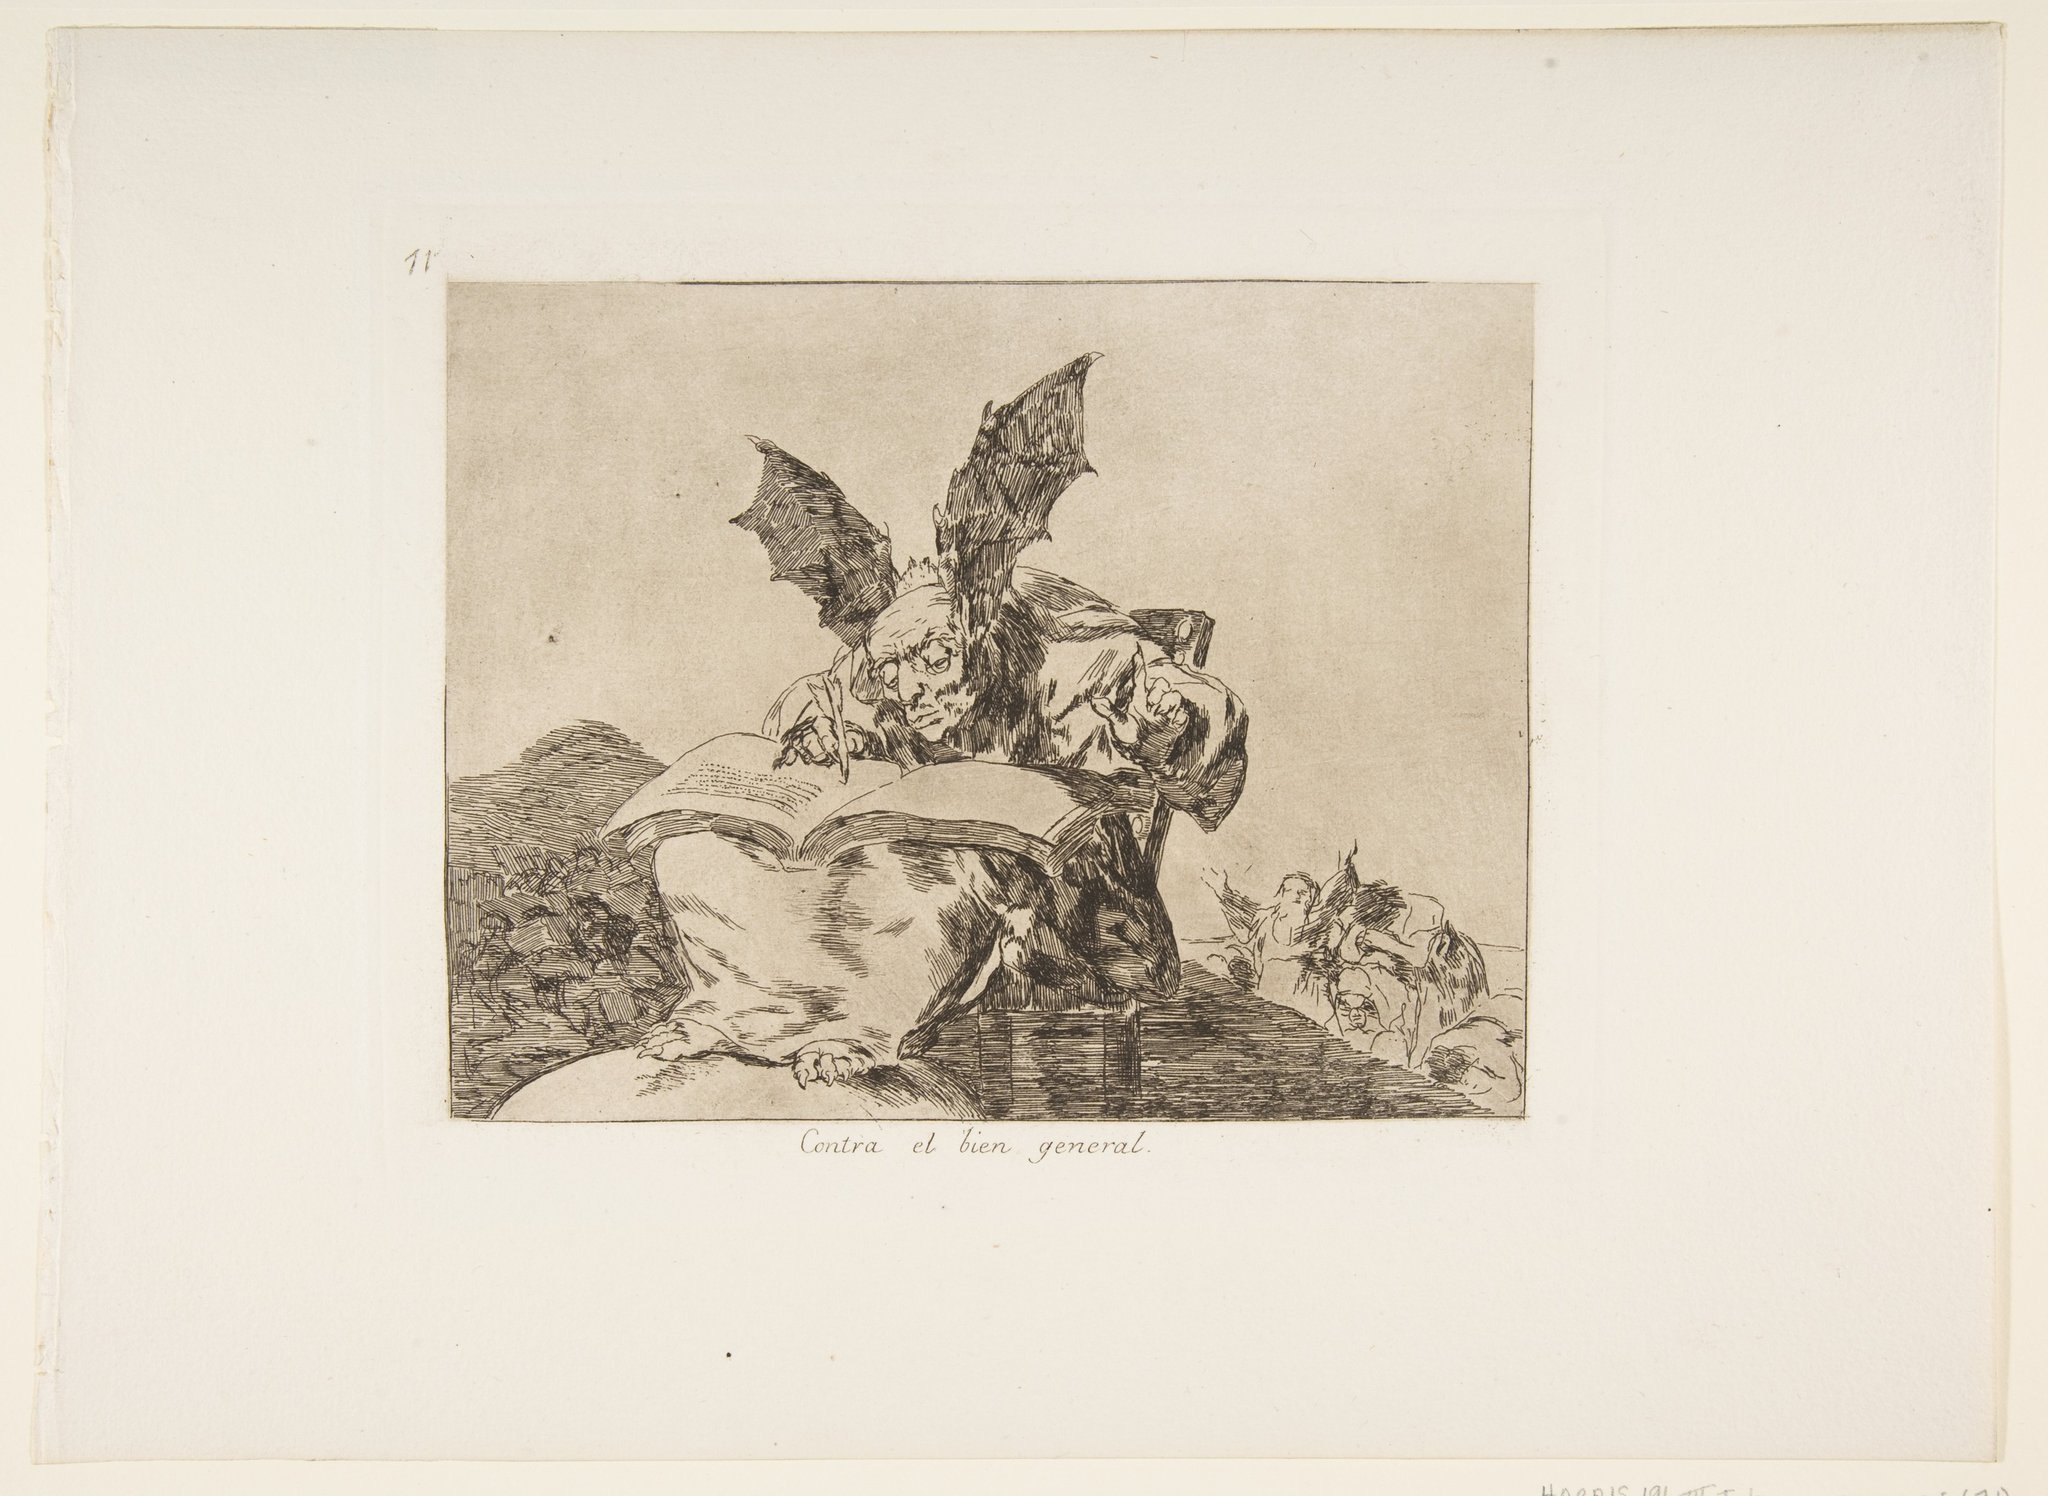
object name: print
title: Plate 71 from "The Disasters of War" (Los Desastres de la Guerra): 'Against the common good' (Contra el bien general)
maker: goya (francisco de goya y lucientes)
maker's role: artist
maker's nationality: spanish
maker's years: 1746-1828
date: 1814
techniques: etching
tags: writing